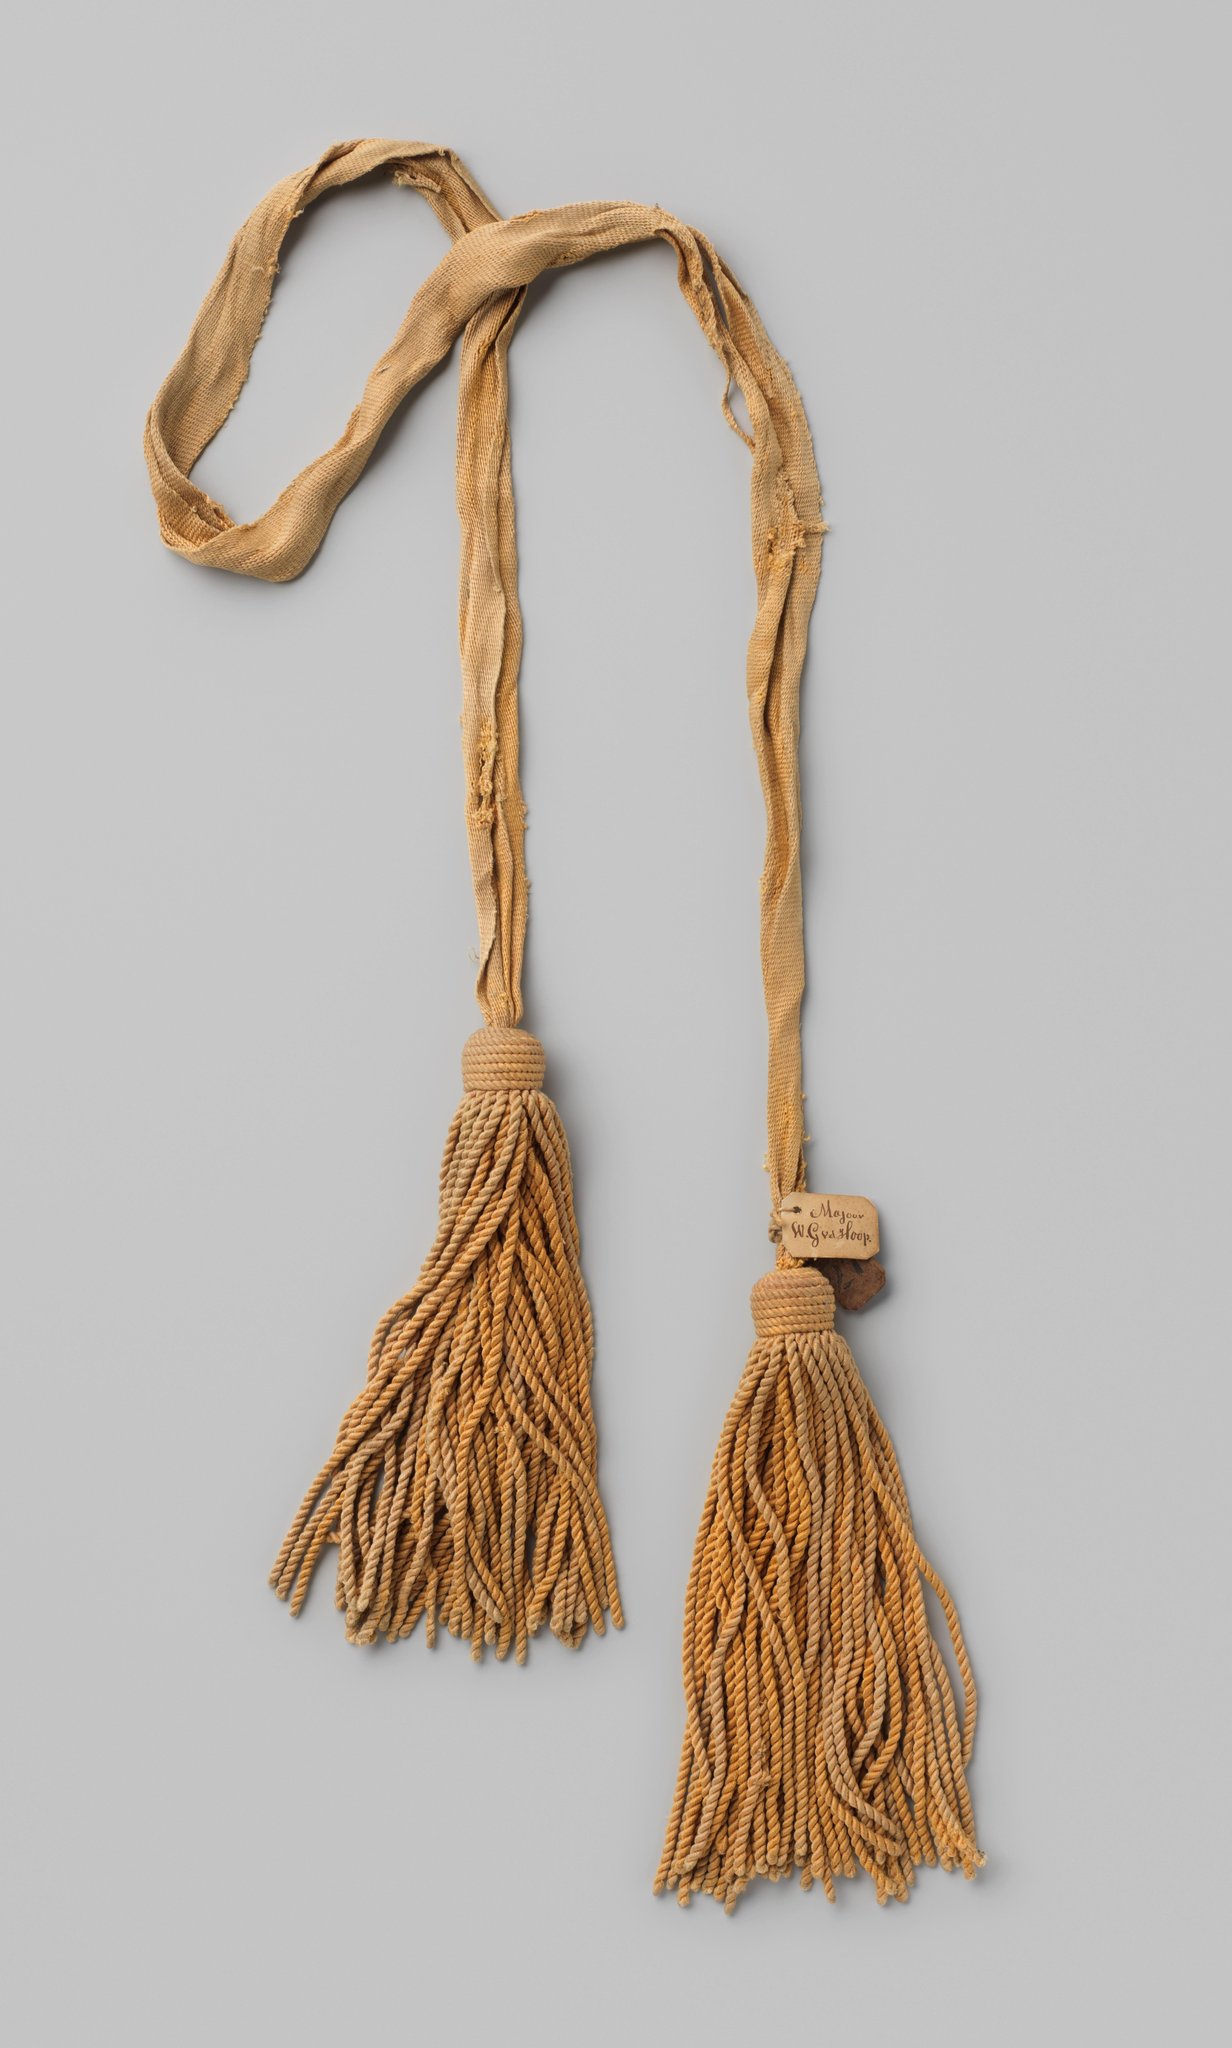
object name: sash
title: Sjerp M. 1815 met kwasten M. 1860, voor officieren leger (vrijwillige jagers?) schutterij of mariniers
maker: Anonymous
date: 1815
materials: silk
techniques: stitching, weave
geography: netherlands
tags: w.g. van der hoop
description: Sjerp van oranje koordzijde, in Egyptisch vlechtwerk, (het geheel verfletst), met gaten. Aan beide zijde kwasten met franje in dito zijde. Sjerp werd geknoopt. Aan een der zijden leren label met nummer 27 en etiket met tekst: Majoor W.G. v.d. Hoop.